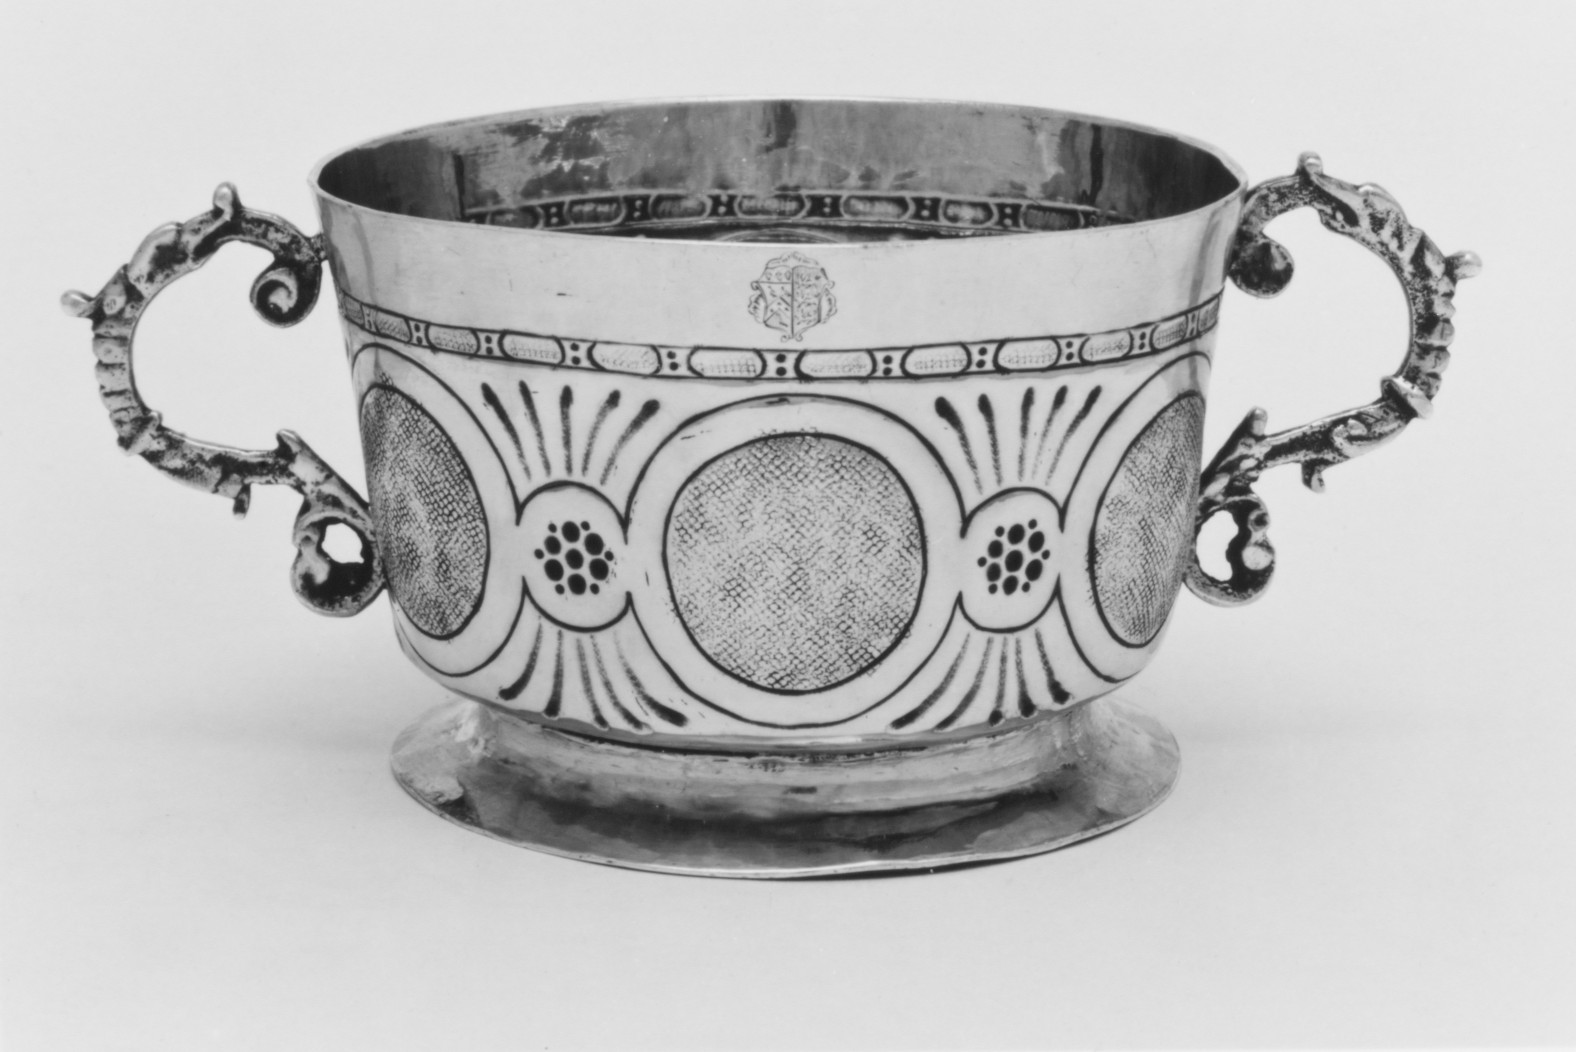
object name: bowl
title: Two-handled bowl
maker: t. g., london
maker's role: maker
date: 1654-1655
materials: silver gilt